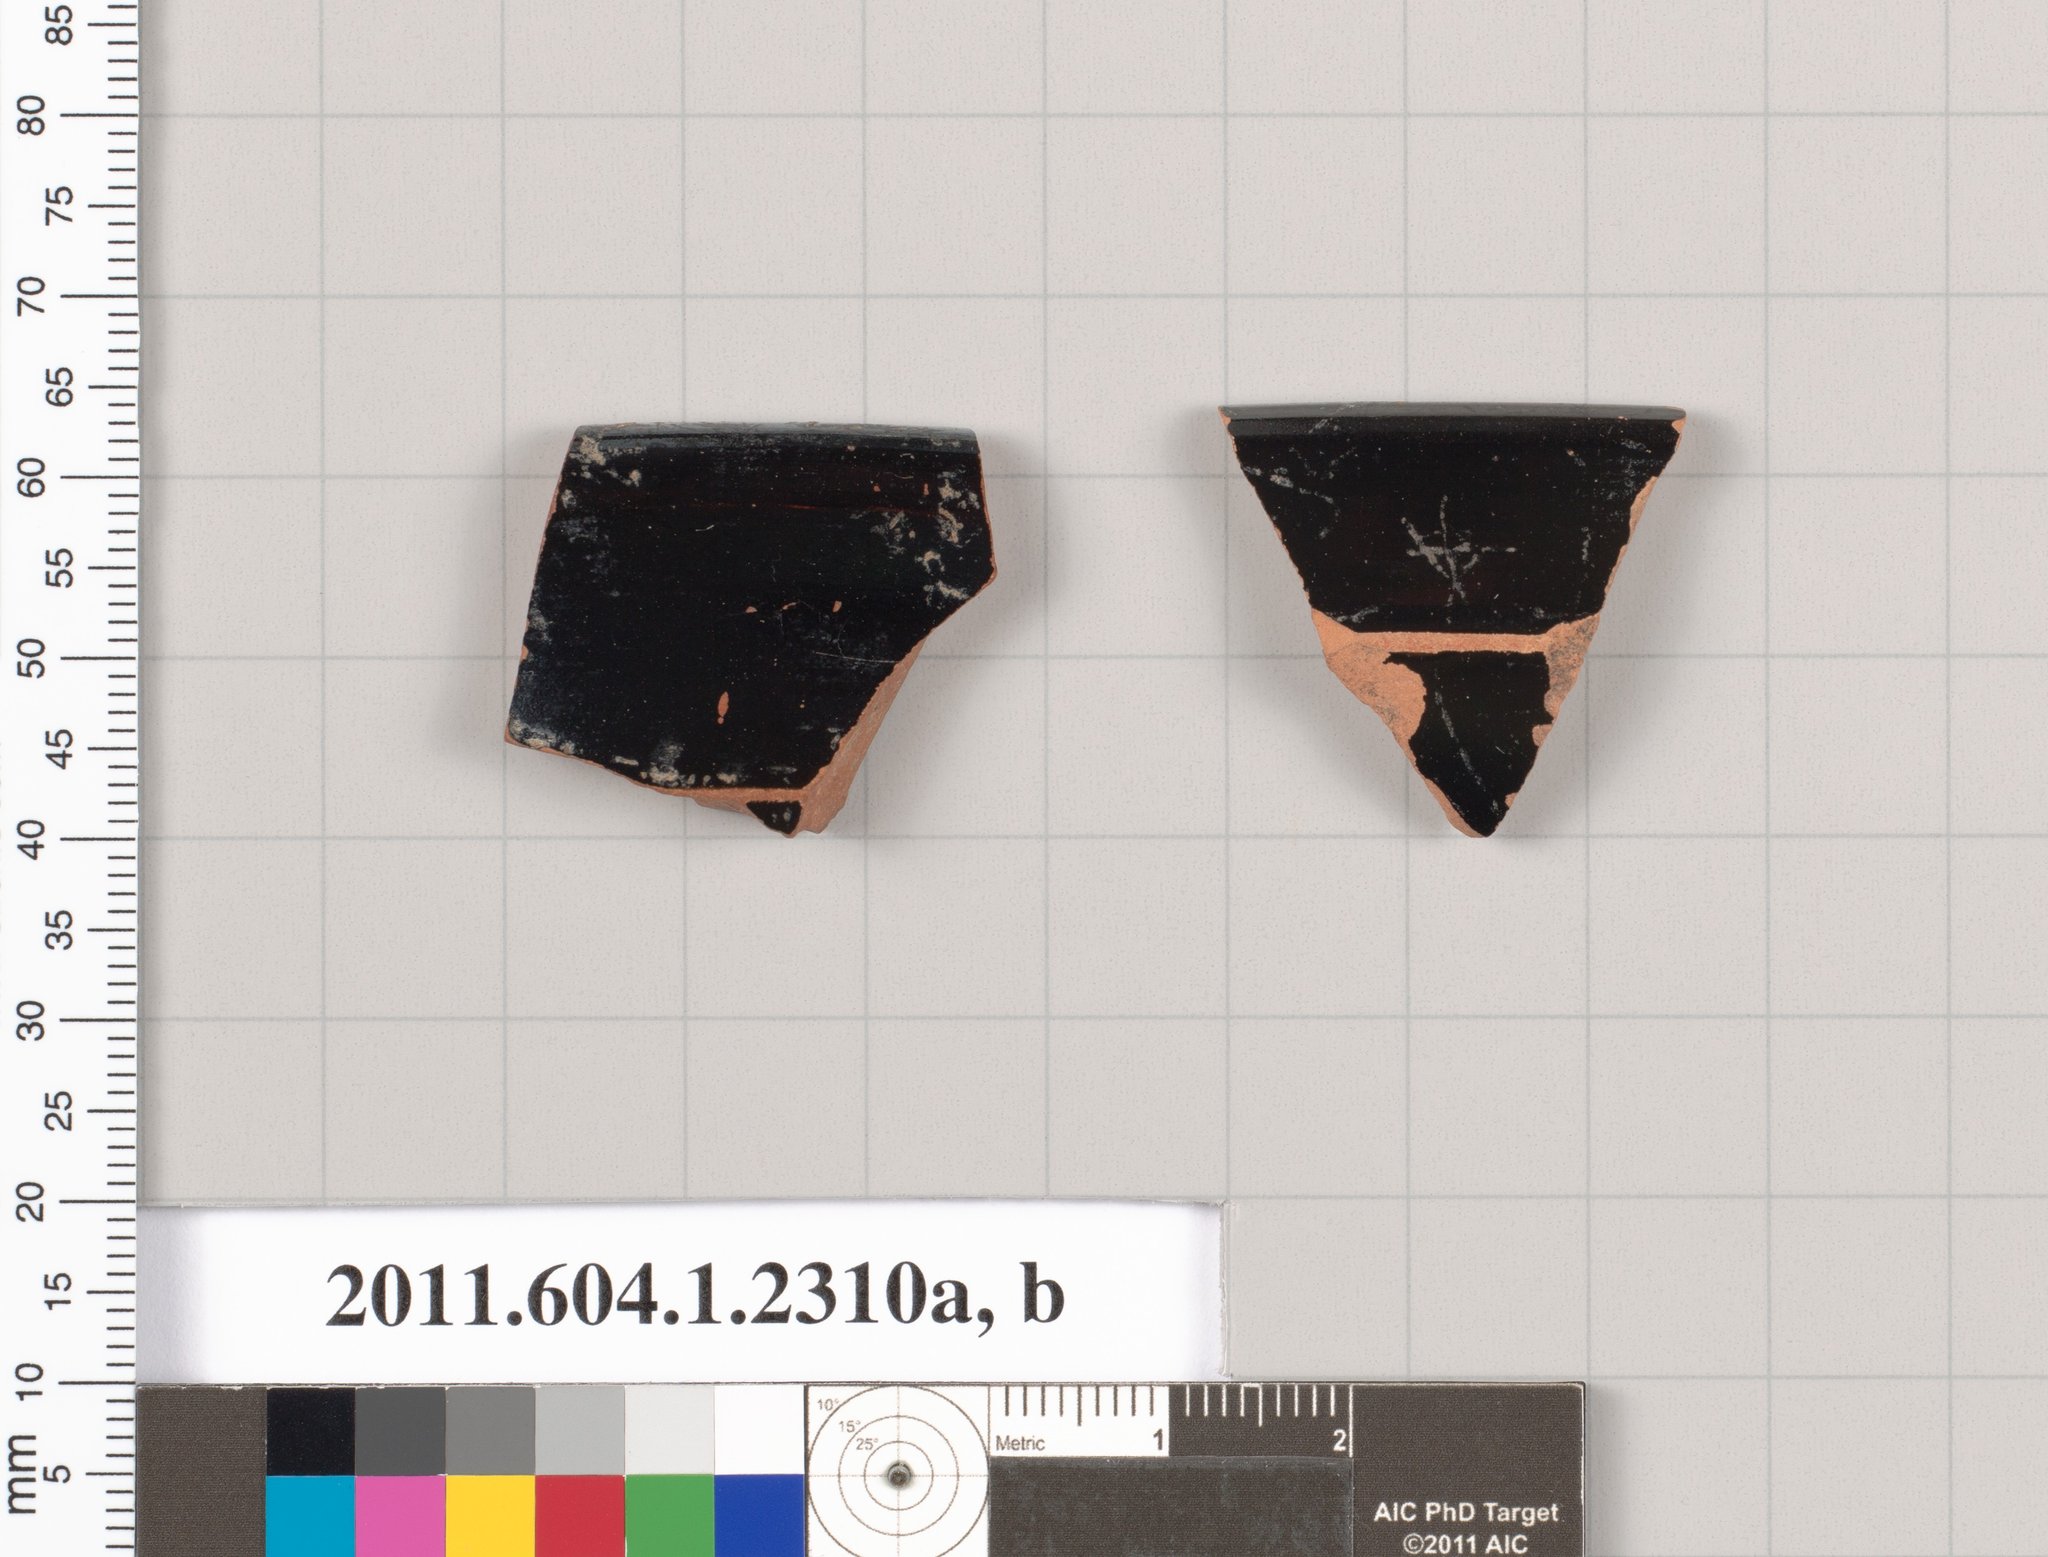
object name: kylix fragment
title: Terracotta rim fragments of kylikes (drinking cups)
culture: greek, attic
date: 500-451 BCE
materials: terracotta